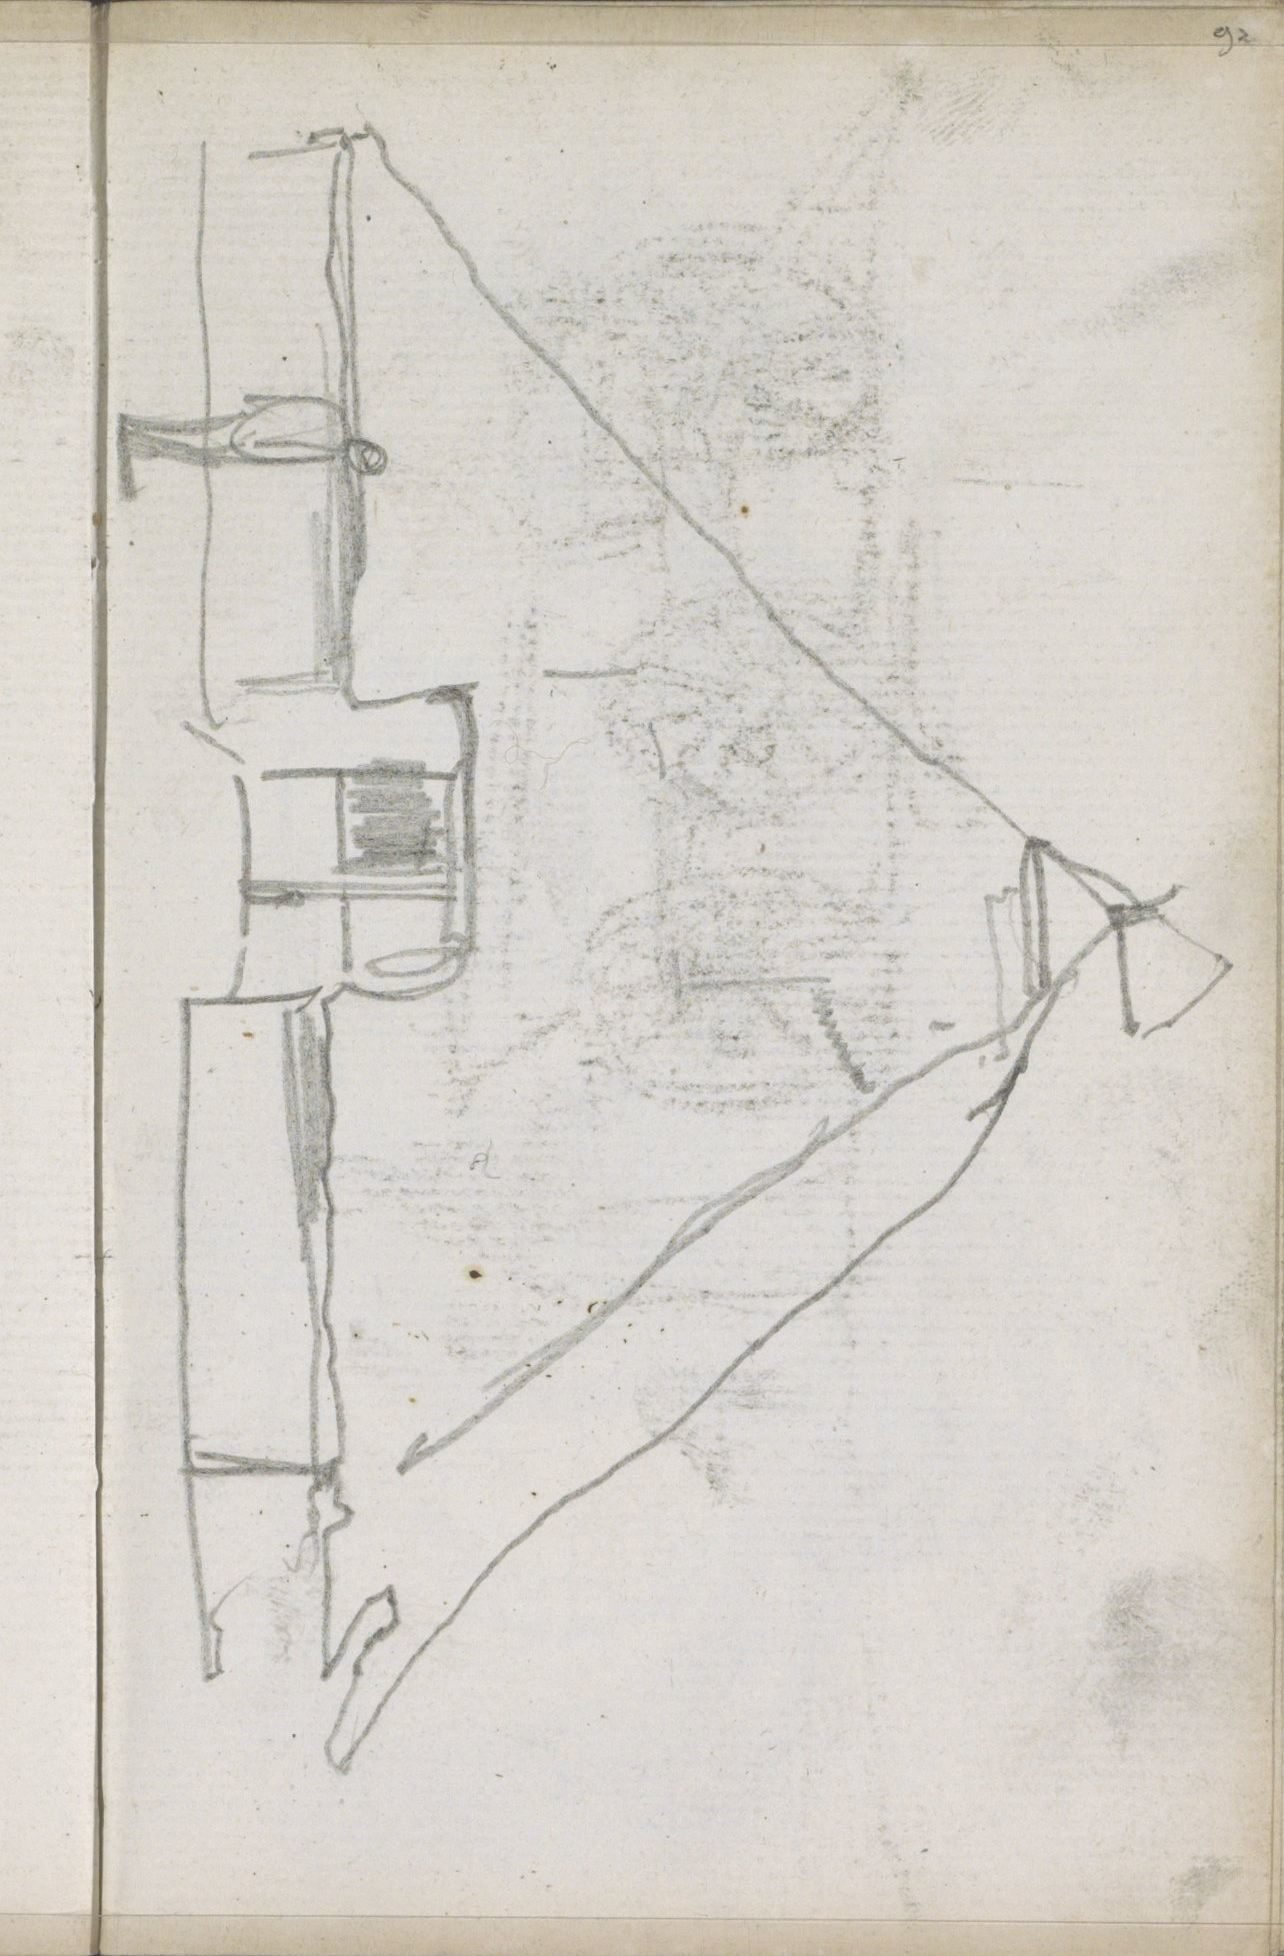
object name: sketchbook leaf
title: Boerderij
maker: george hendrik breitner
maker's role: draughtsman, painter, print maker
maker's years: 1857-1923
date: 1884-1886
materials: paper, pencil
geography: drenthe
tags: farm (building)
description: Pagina 92 uit een schetsboek met 67 bladen vervaardigd in Drenthe.